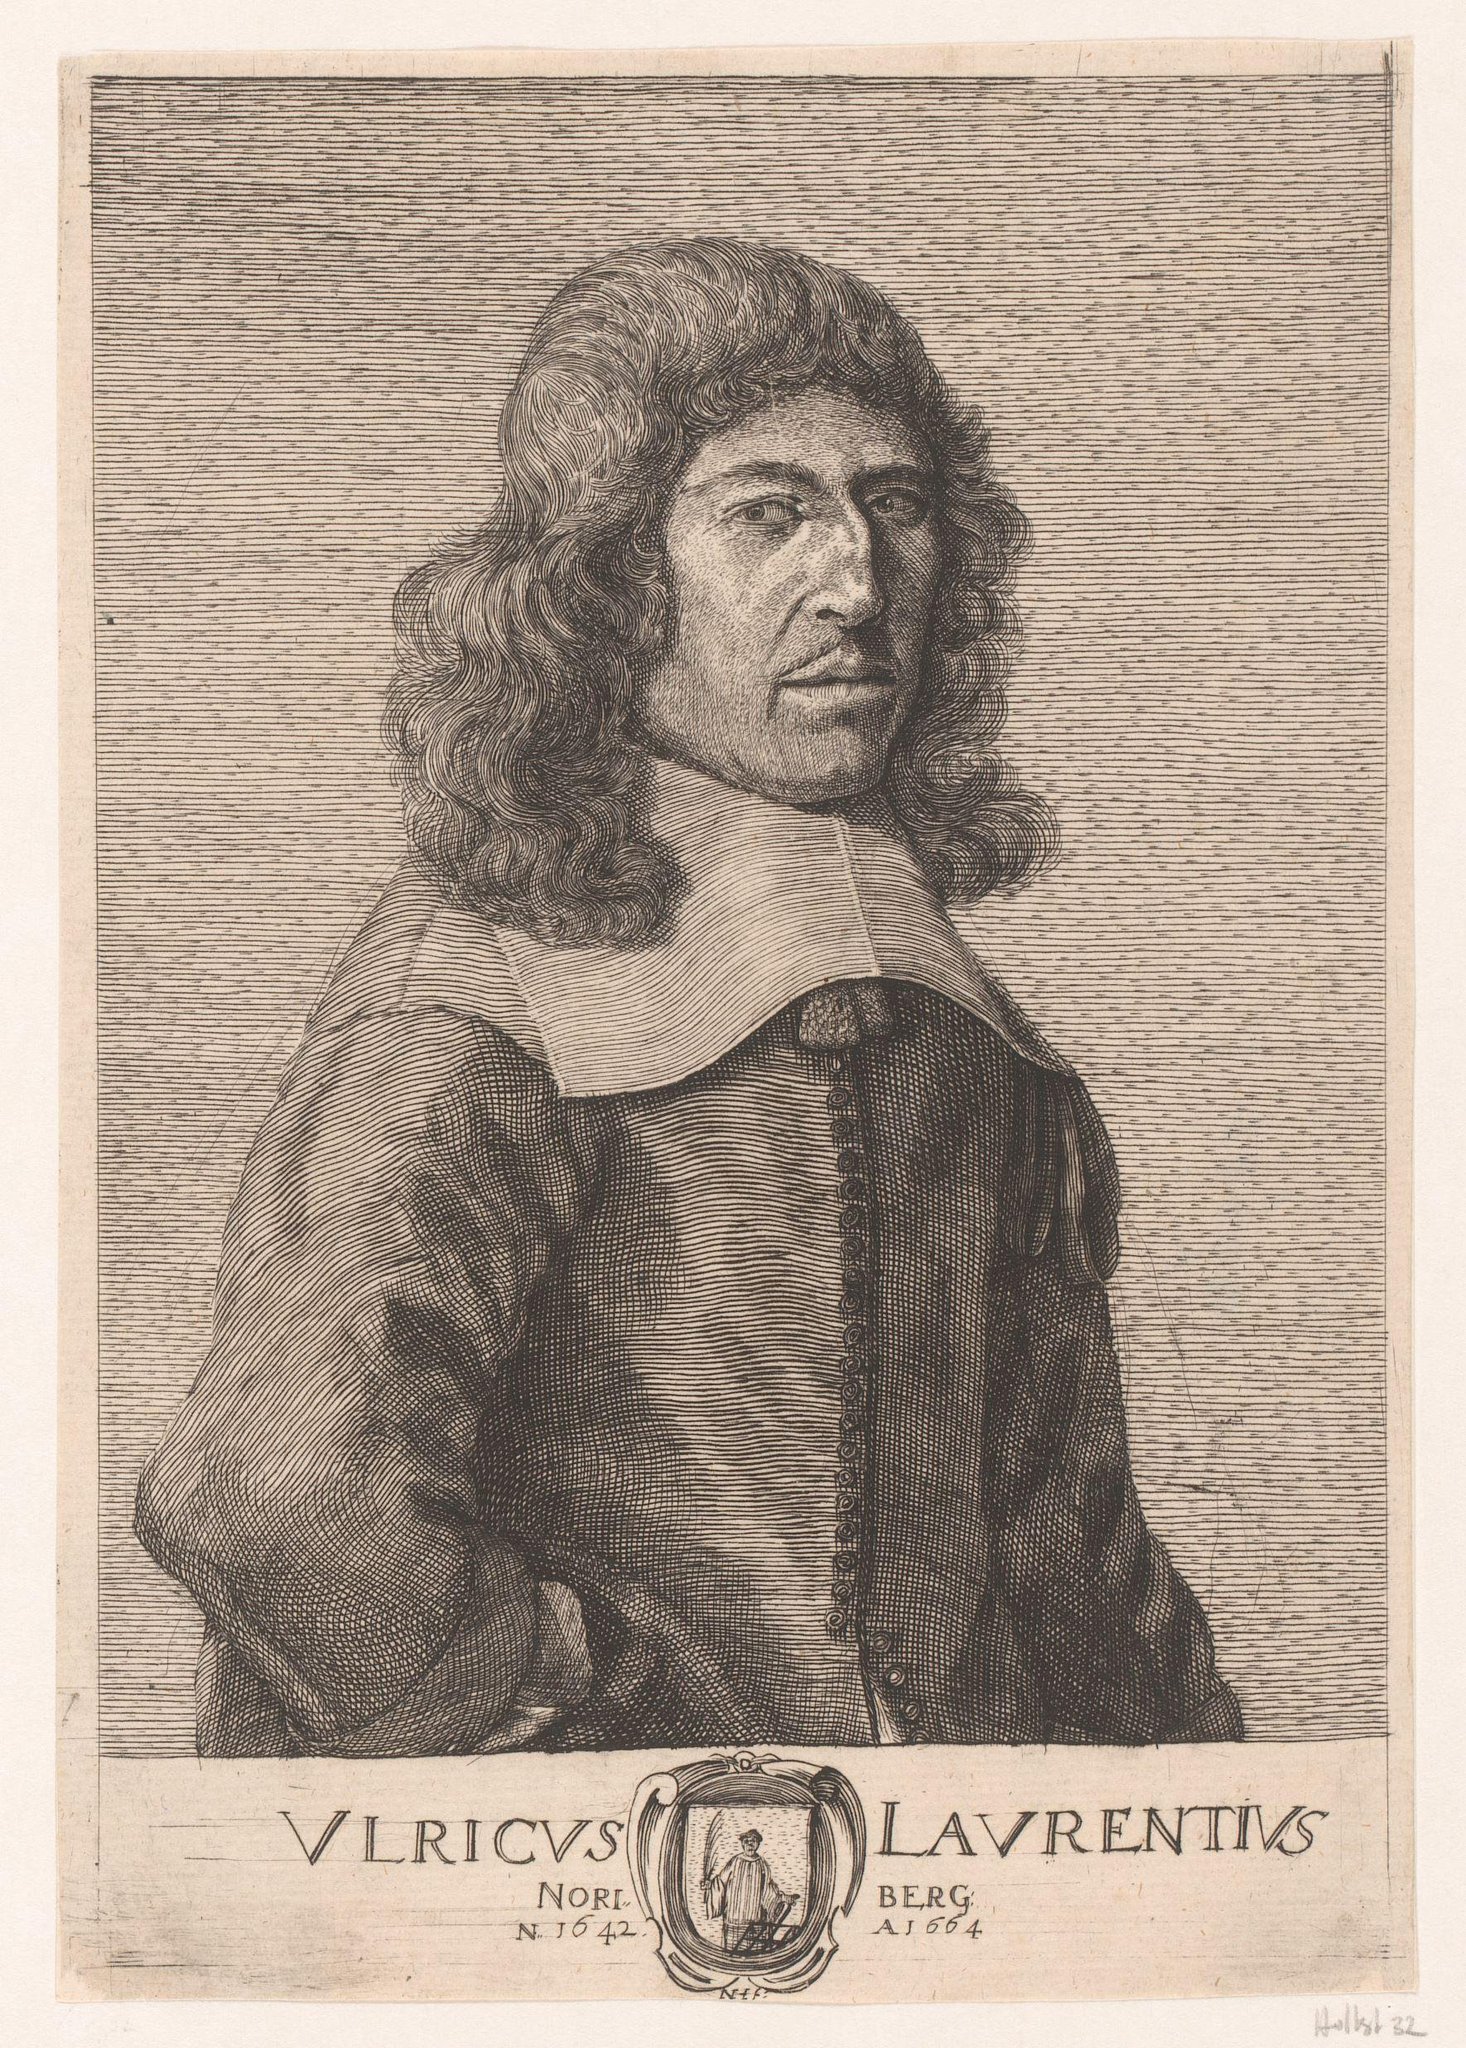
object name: print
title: Portret van Ulrich Laurentius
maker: nicolaus häublin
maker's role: print maker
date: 1664-1685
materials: paper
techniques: engraving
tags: historical persons, armorial bearing, heraldry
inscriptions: collector's mark: Lugt 2166